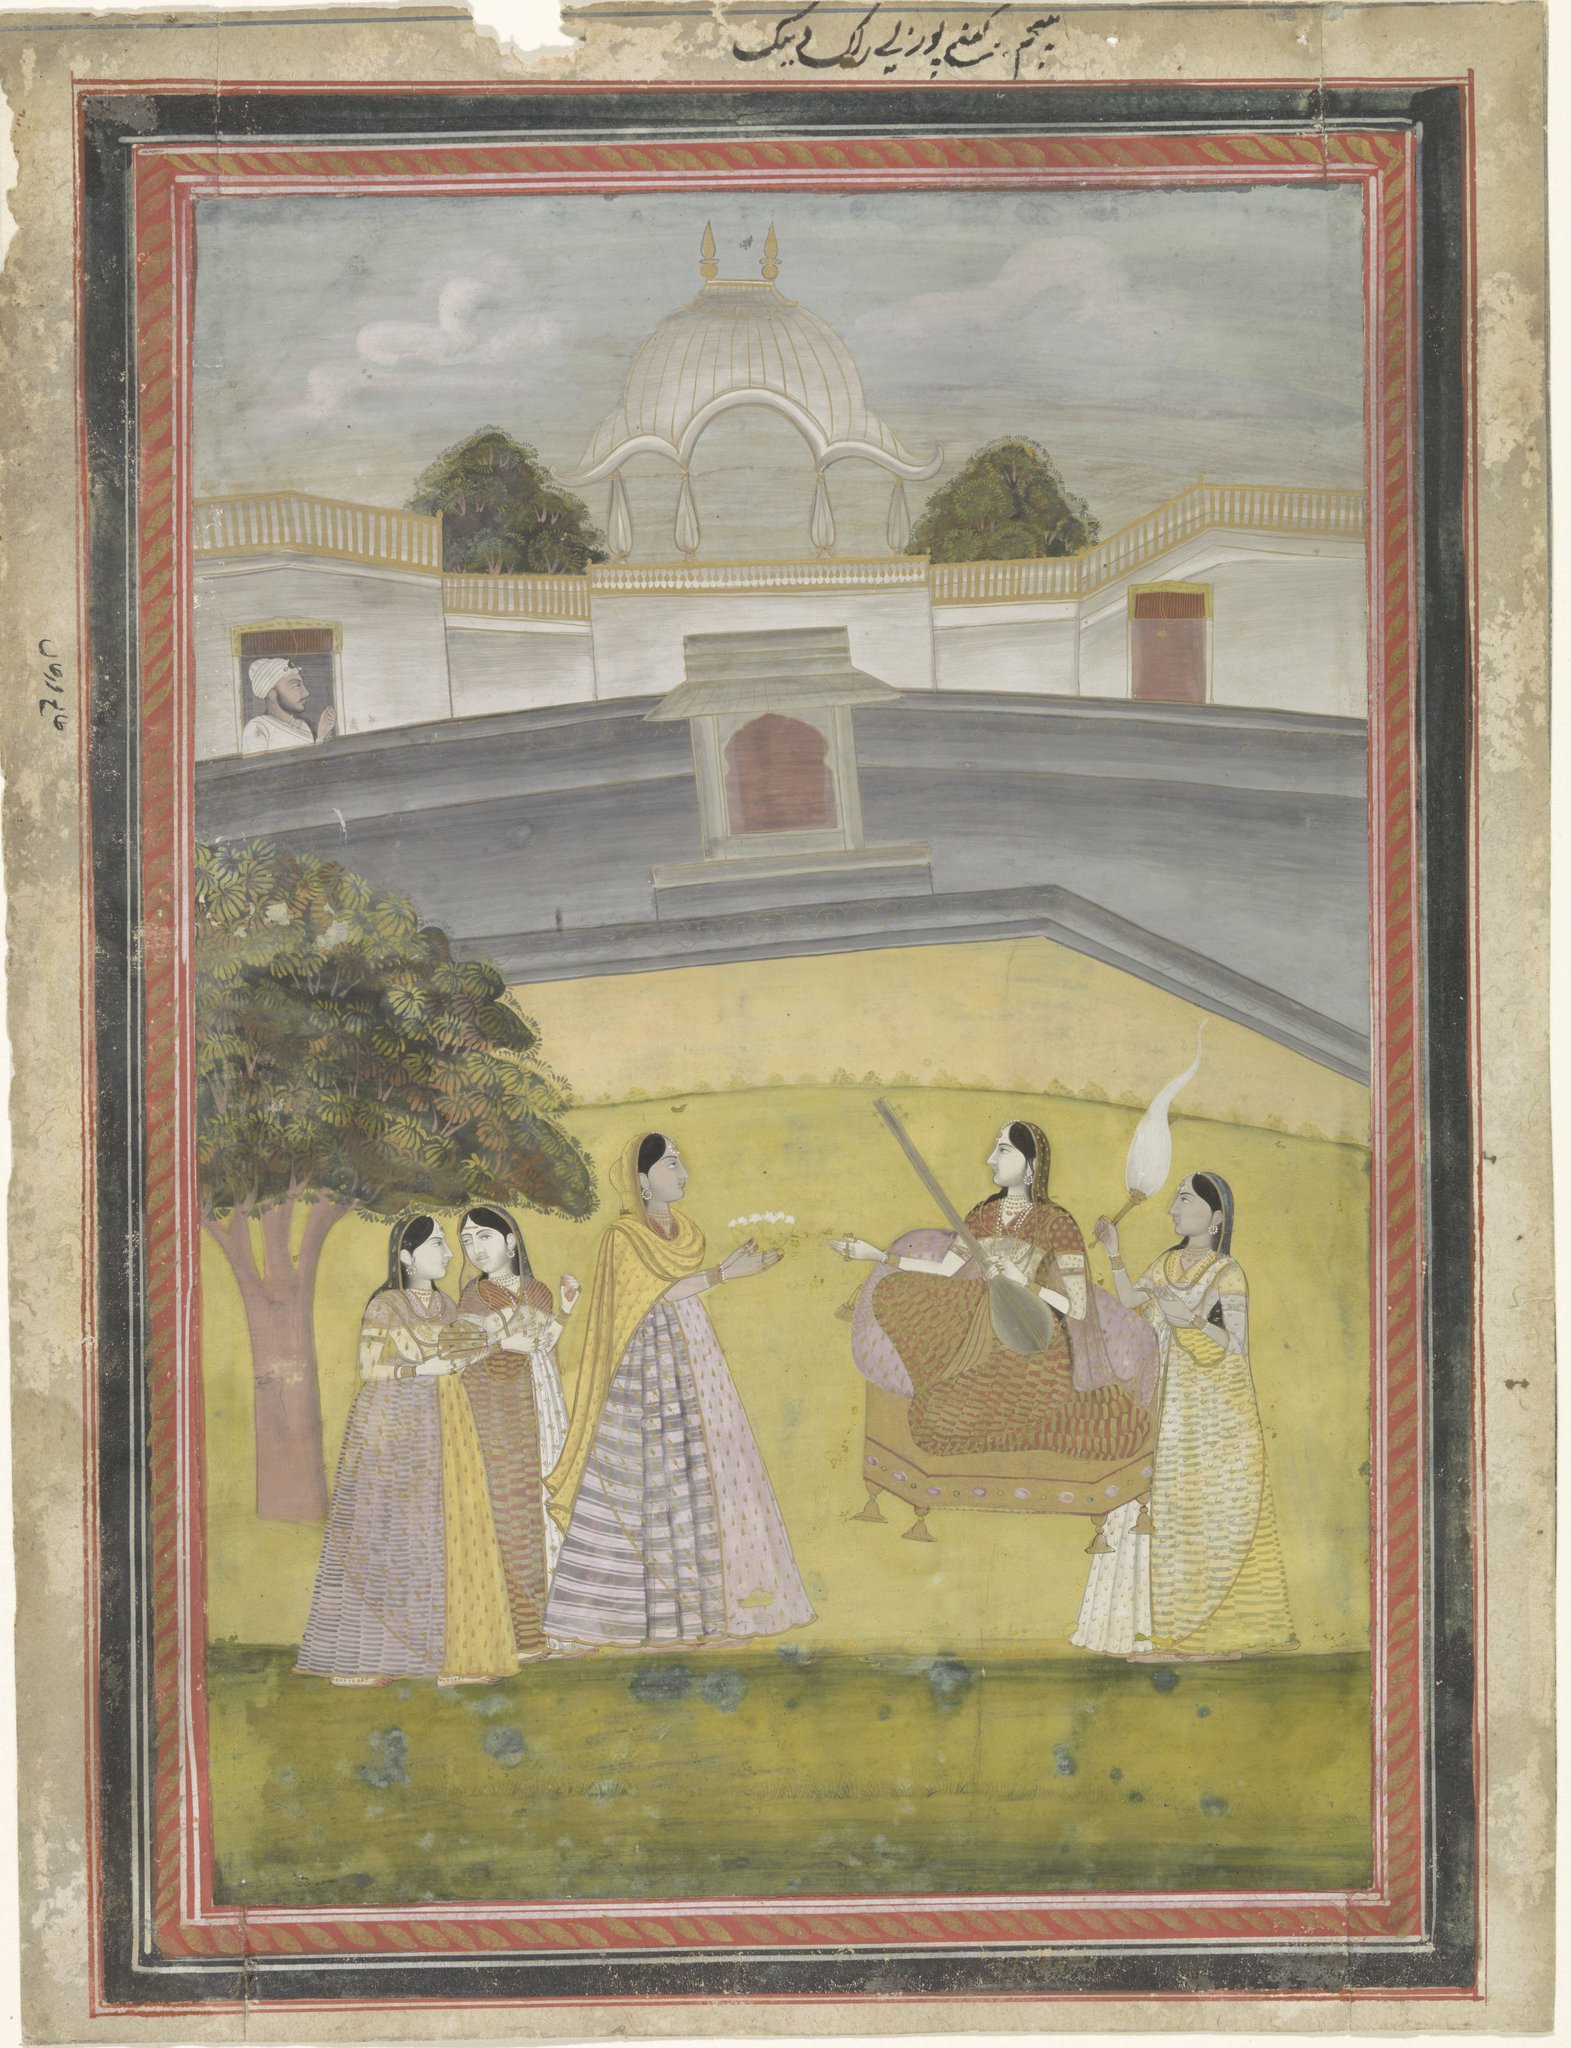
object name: drawing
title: Vrouwen in een tuin voor een paleis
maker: Anonymous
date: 1770-1790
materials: paper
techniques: brush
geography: farukhabad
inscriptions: inscription: ‘Thaliwar Khan [zoon van Ahmad Khan]’